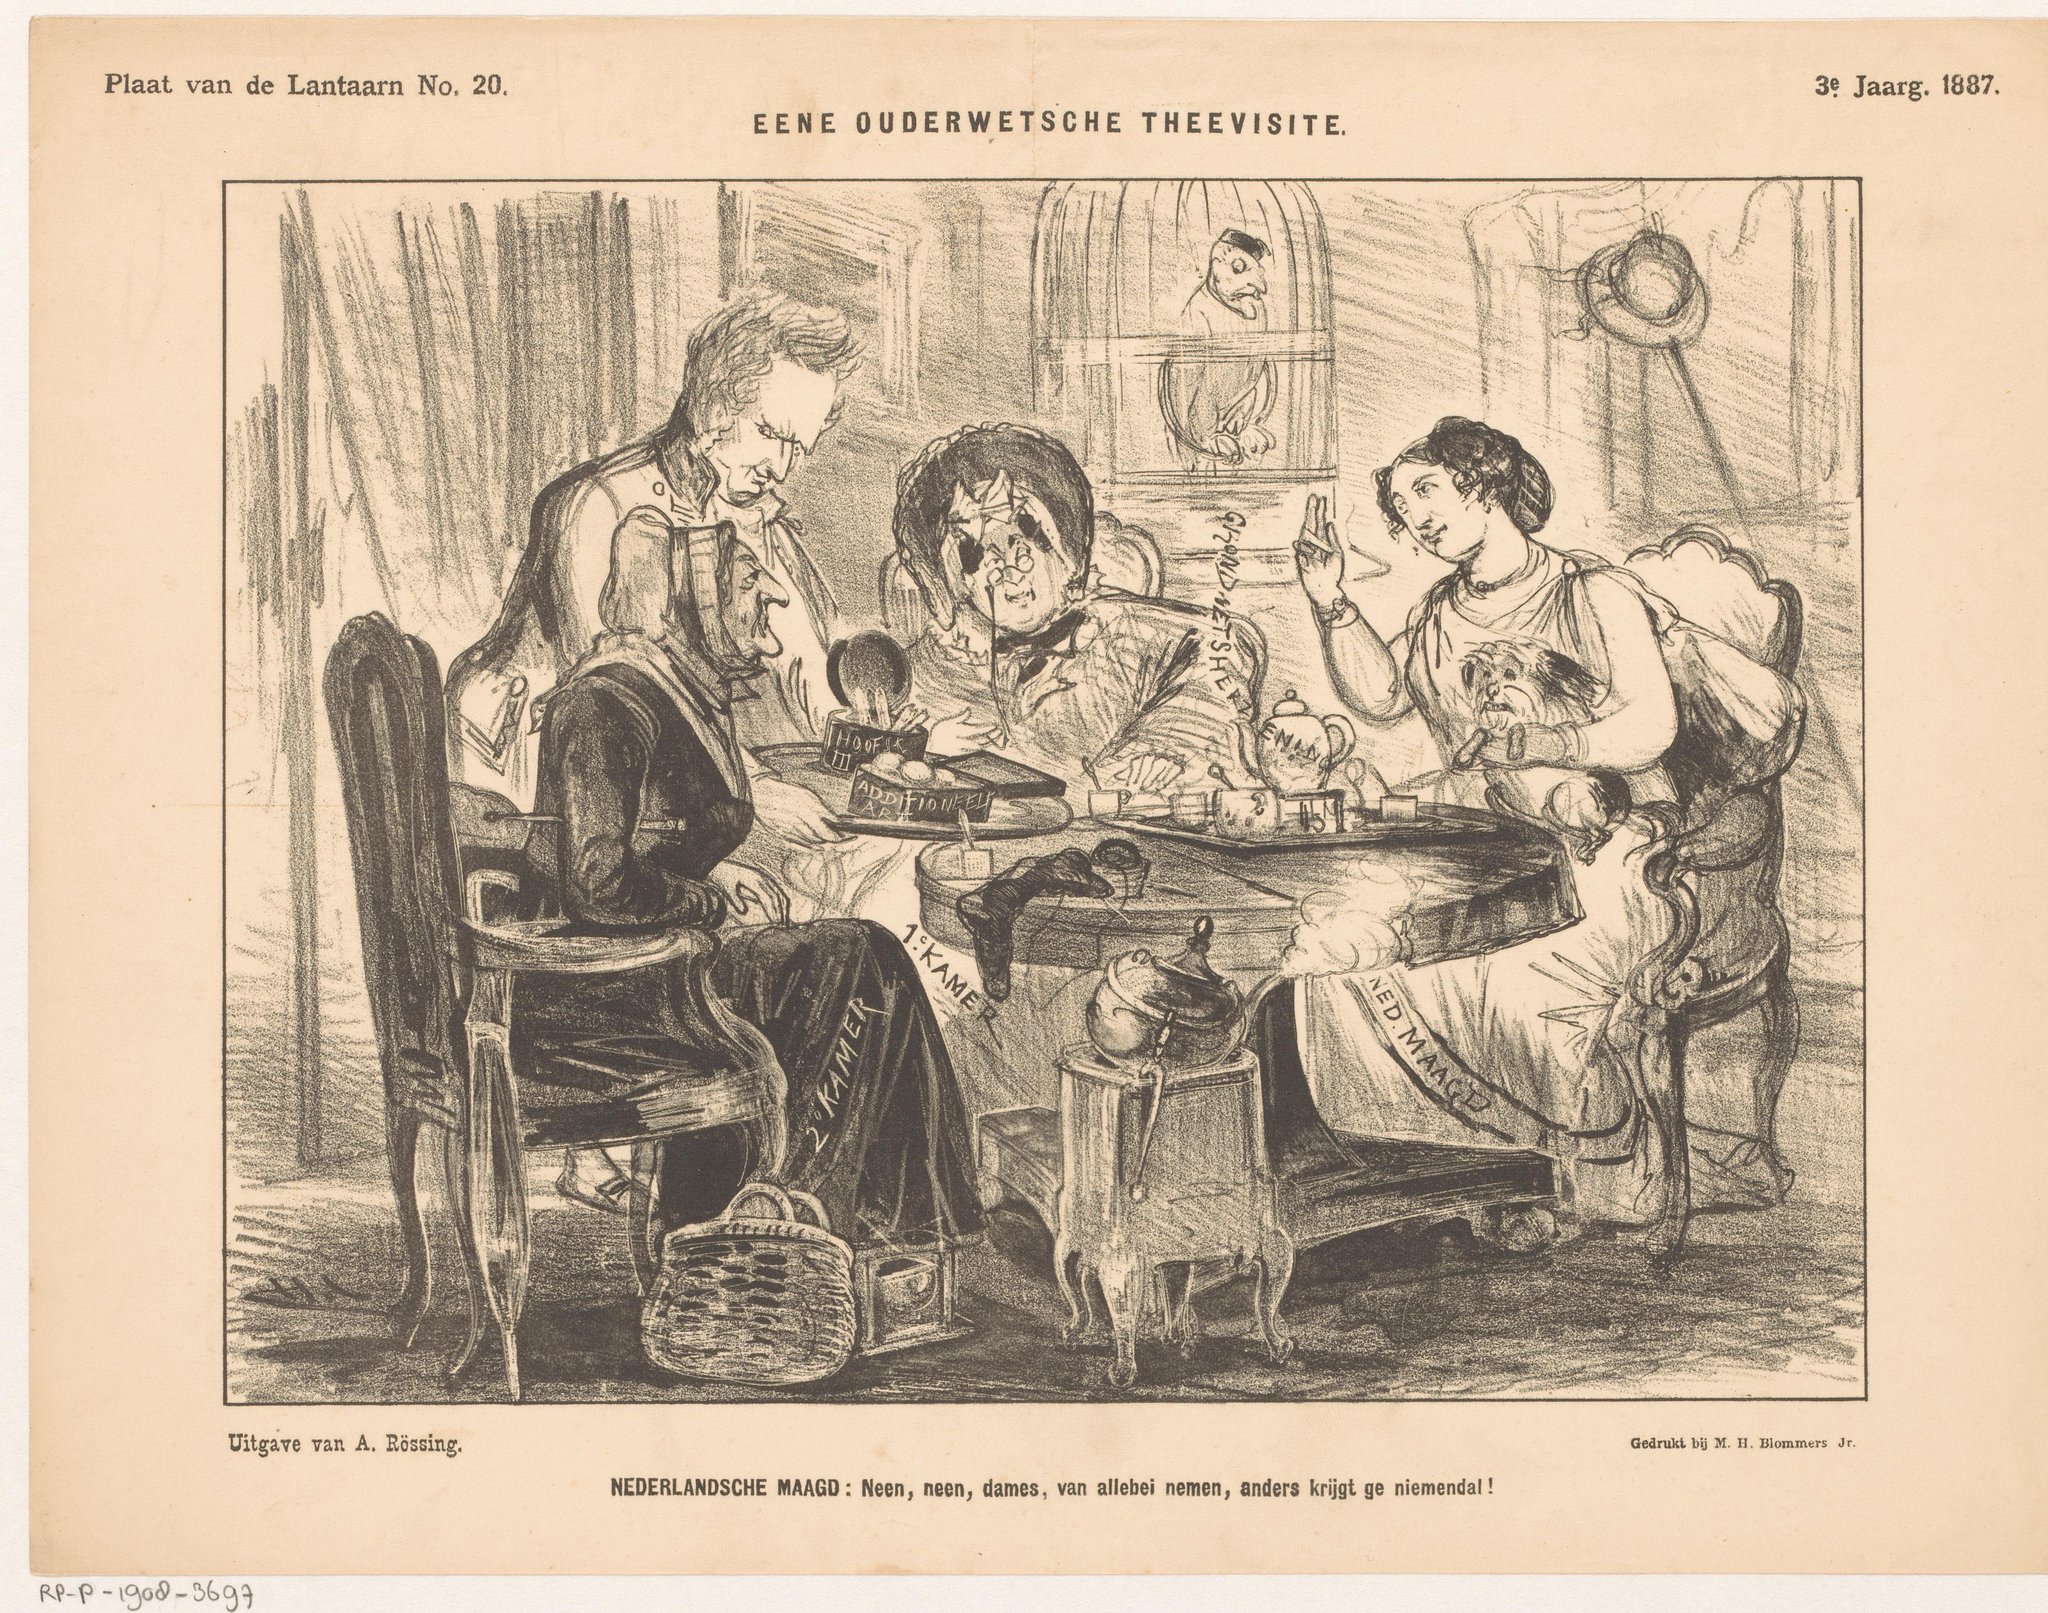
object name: cartoon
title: Eene ouderwetsche theevisite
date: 1887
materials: paper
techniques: lithograph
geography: the hague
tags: afternoon tea, political caricatures and satires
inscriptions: collector's mark: Lugt 2228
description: De Eerste en Tweede Kamer, in de vorm van twee vrouwen, zitten aan tafel bij de Nederlandse Maagd, een jonge vrouw met een hond op schoot. Zij drinken thee. De Nederlandse Maagd spoort de twee dames aan om beiden koekjes, aangeboden door de bediende, te nemen. Op de trommels staan verwijzingen naar de artikelen van de grondwet. Deze prent werd uitgegeven bij De Lantaarn.